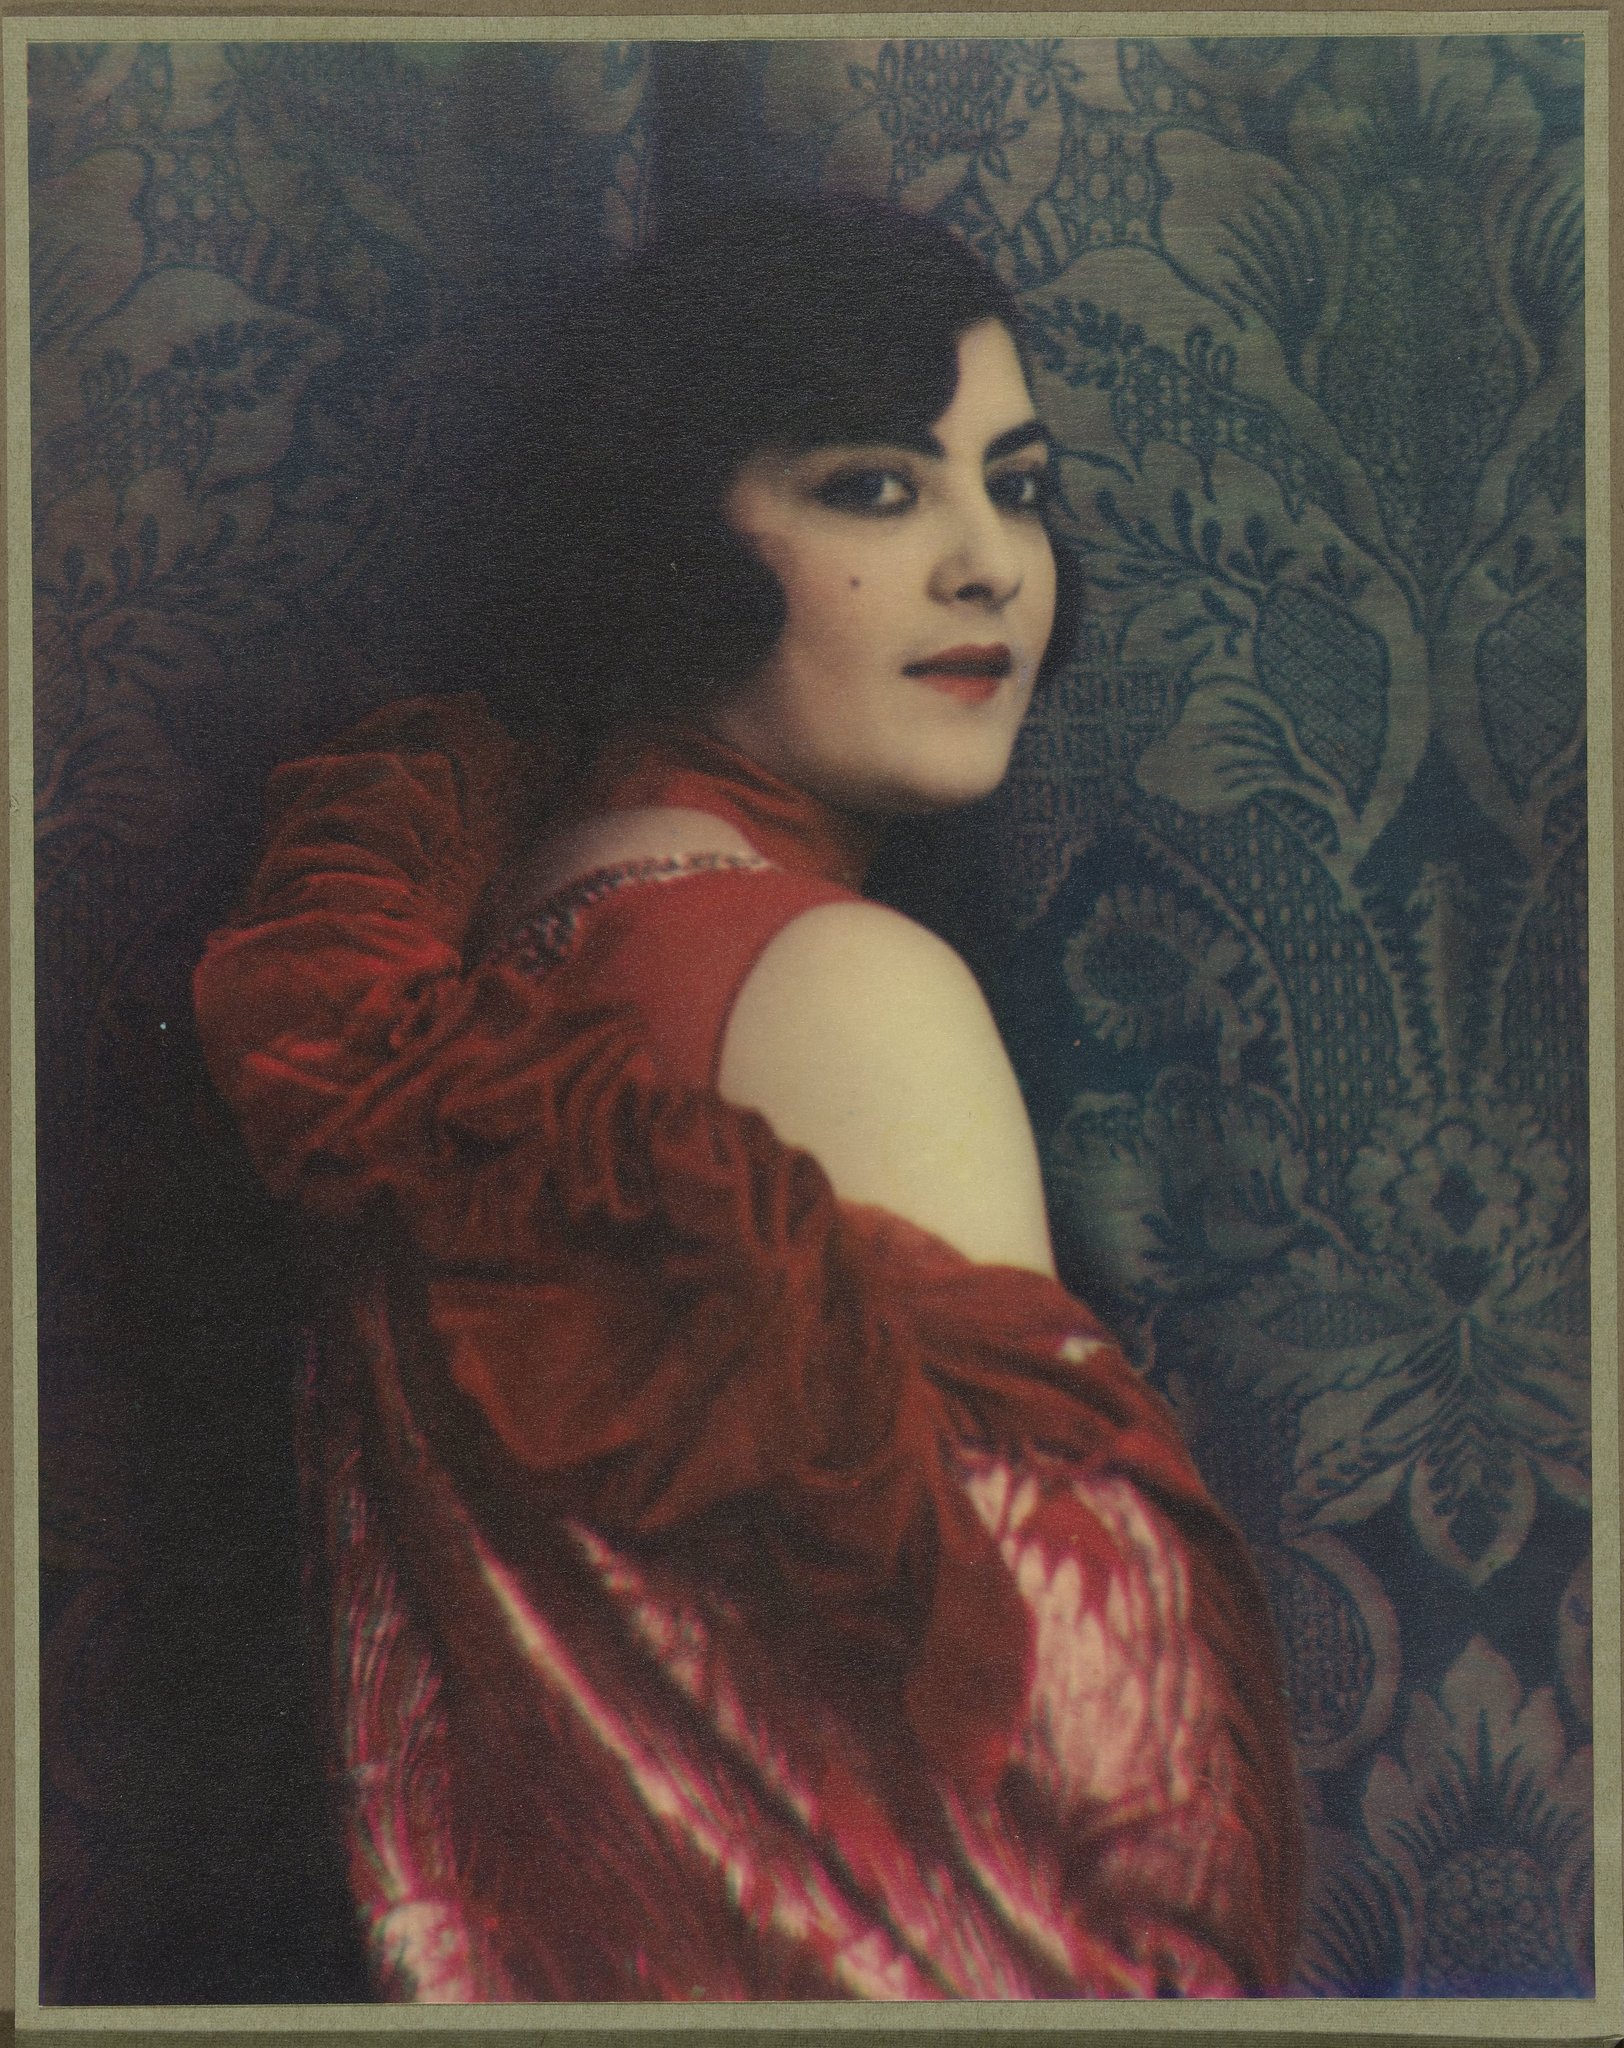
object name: photograph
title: Portret van een vrouw in een rode jurk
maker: jacob merkelbach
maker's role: fotograaf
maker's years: 1877-1942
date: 1920-1930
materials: cardboard, paper, photographic support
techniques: jos-pé print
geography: amsterdam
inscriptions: inscription: ‘Argentijnse actrice’